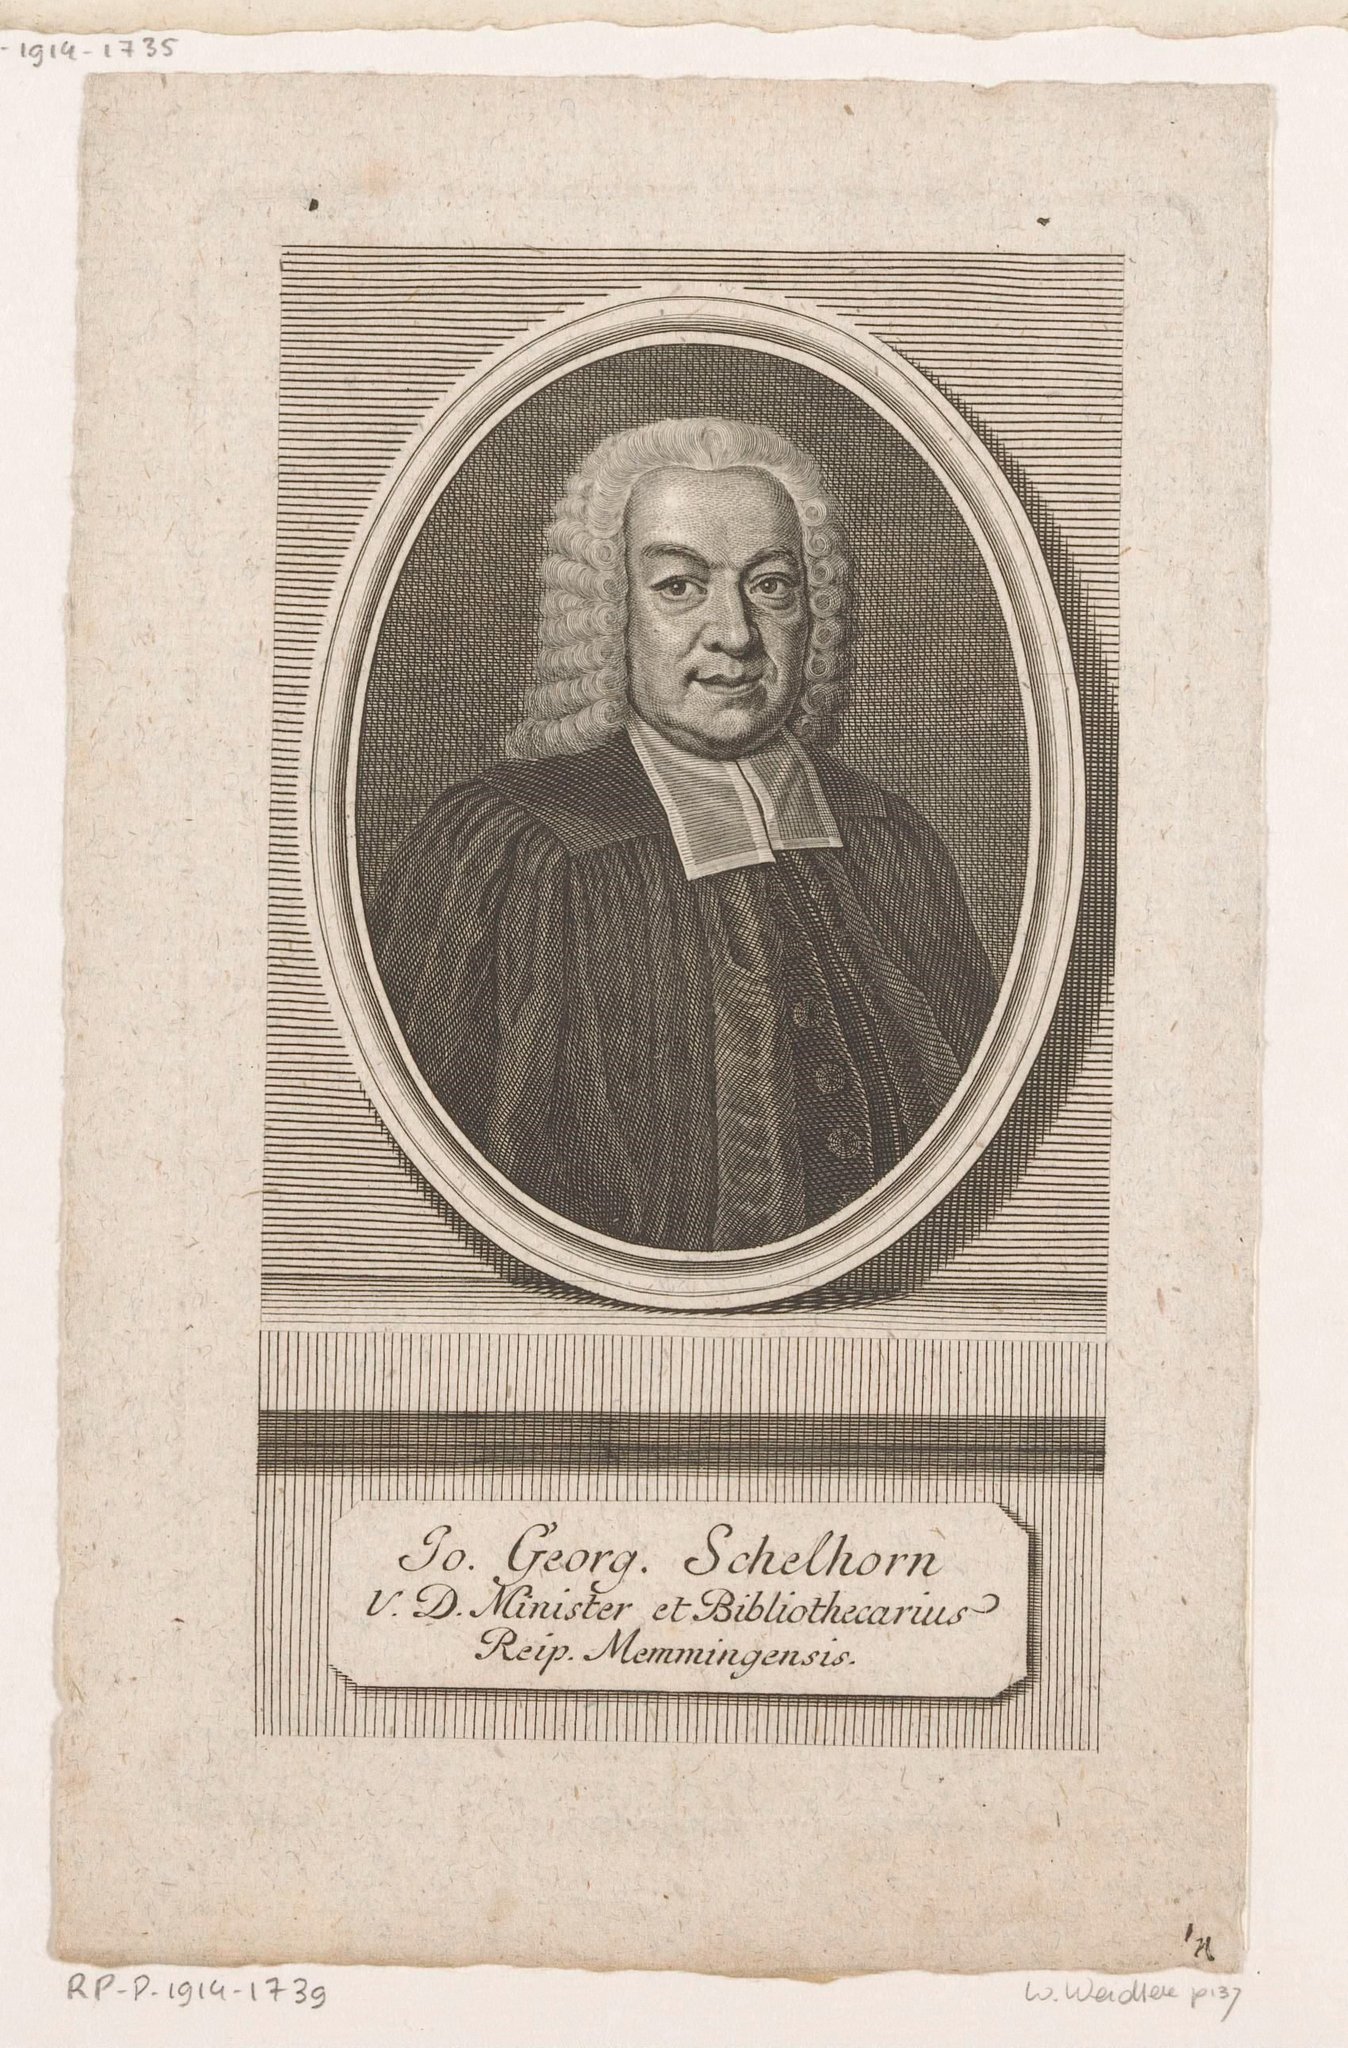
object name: print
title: Portret van Johann Georg Schelhorn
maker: johann martin bernigeroth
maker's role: print maker, publisher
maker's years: 1713-1767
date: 1748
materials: paper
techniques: engraving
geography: leipzig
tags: historical persons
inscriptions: collector's mark: Lugt 2228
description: Prent ook gebruikt in: Zuverlässige Nachrichten von dem gegenwärtigen Zustande, Veränderung und Wachsthum der Wissenschaften. dl. 101. Leipzig: Johann Friedrich Gleditsch, 1748.